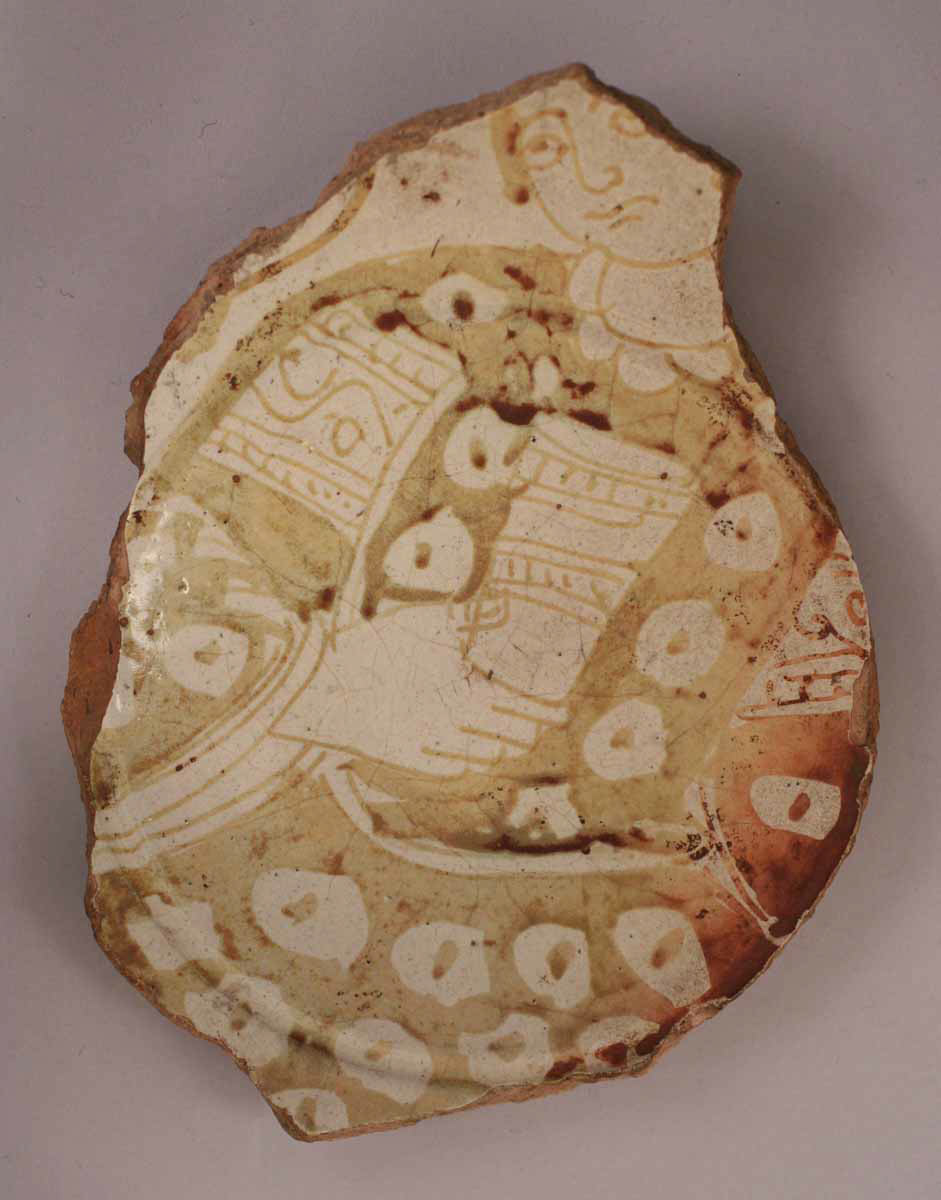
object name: fragment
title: Ceramic Fragment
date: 901-1200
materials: earthenware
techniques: glazing, luster painting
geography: egypt